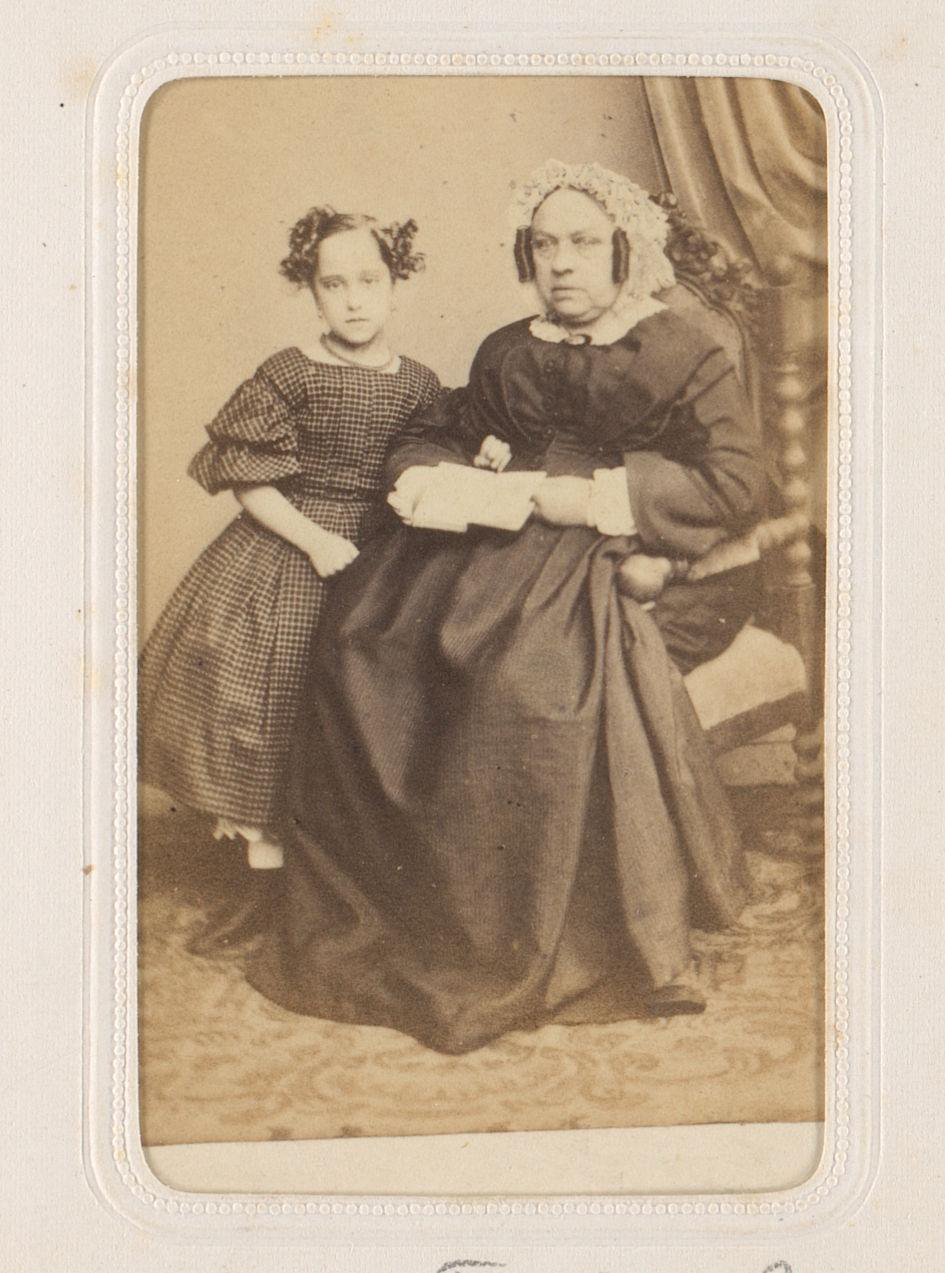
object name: album leaf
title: Portret van een vrouw en meisje in klederdracht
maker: charles binger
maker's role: print maker, printer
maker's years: 1830-1916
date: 1862-1869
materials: cardboard, photographic support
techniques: albumen print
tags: historical persons, head-gear: cap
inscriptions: inscription: ‘CHs Binger & Cie/ Zylstraat, Haarlem’